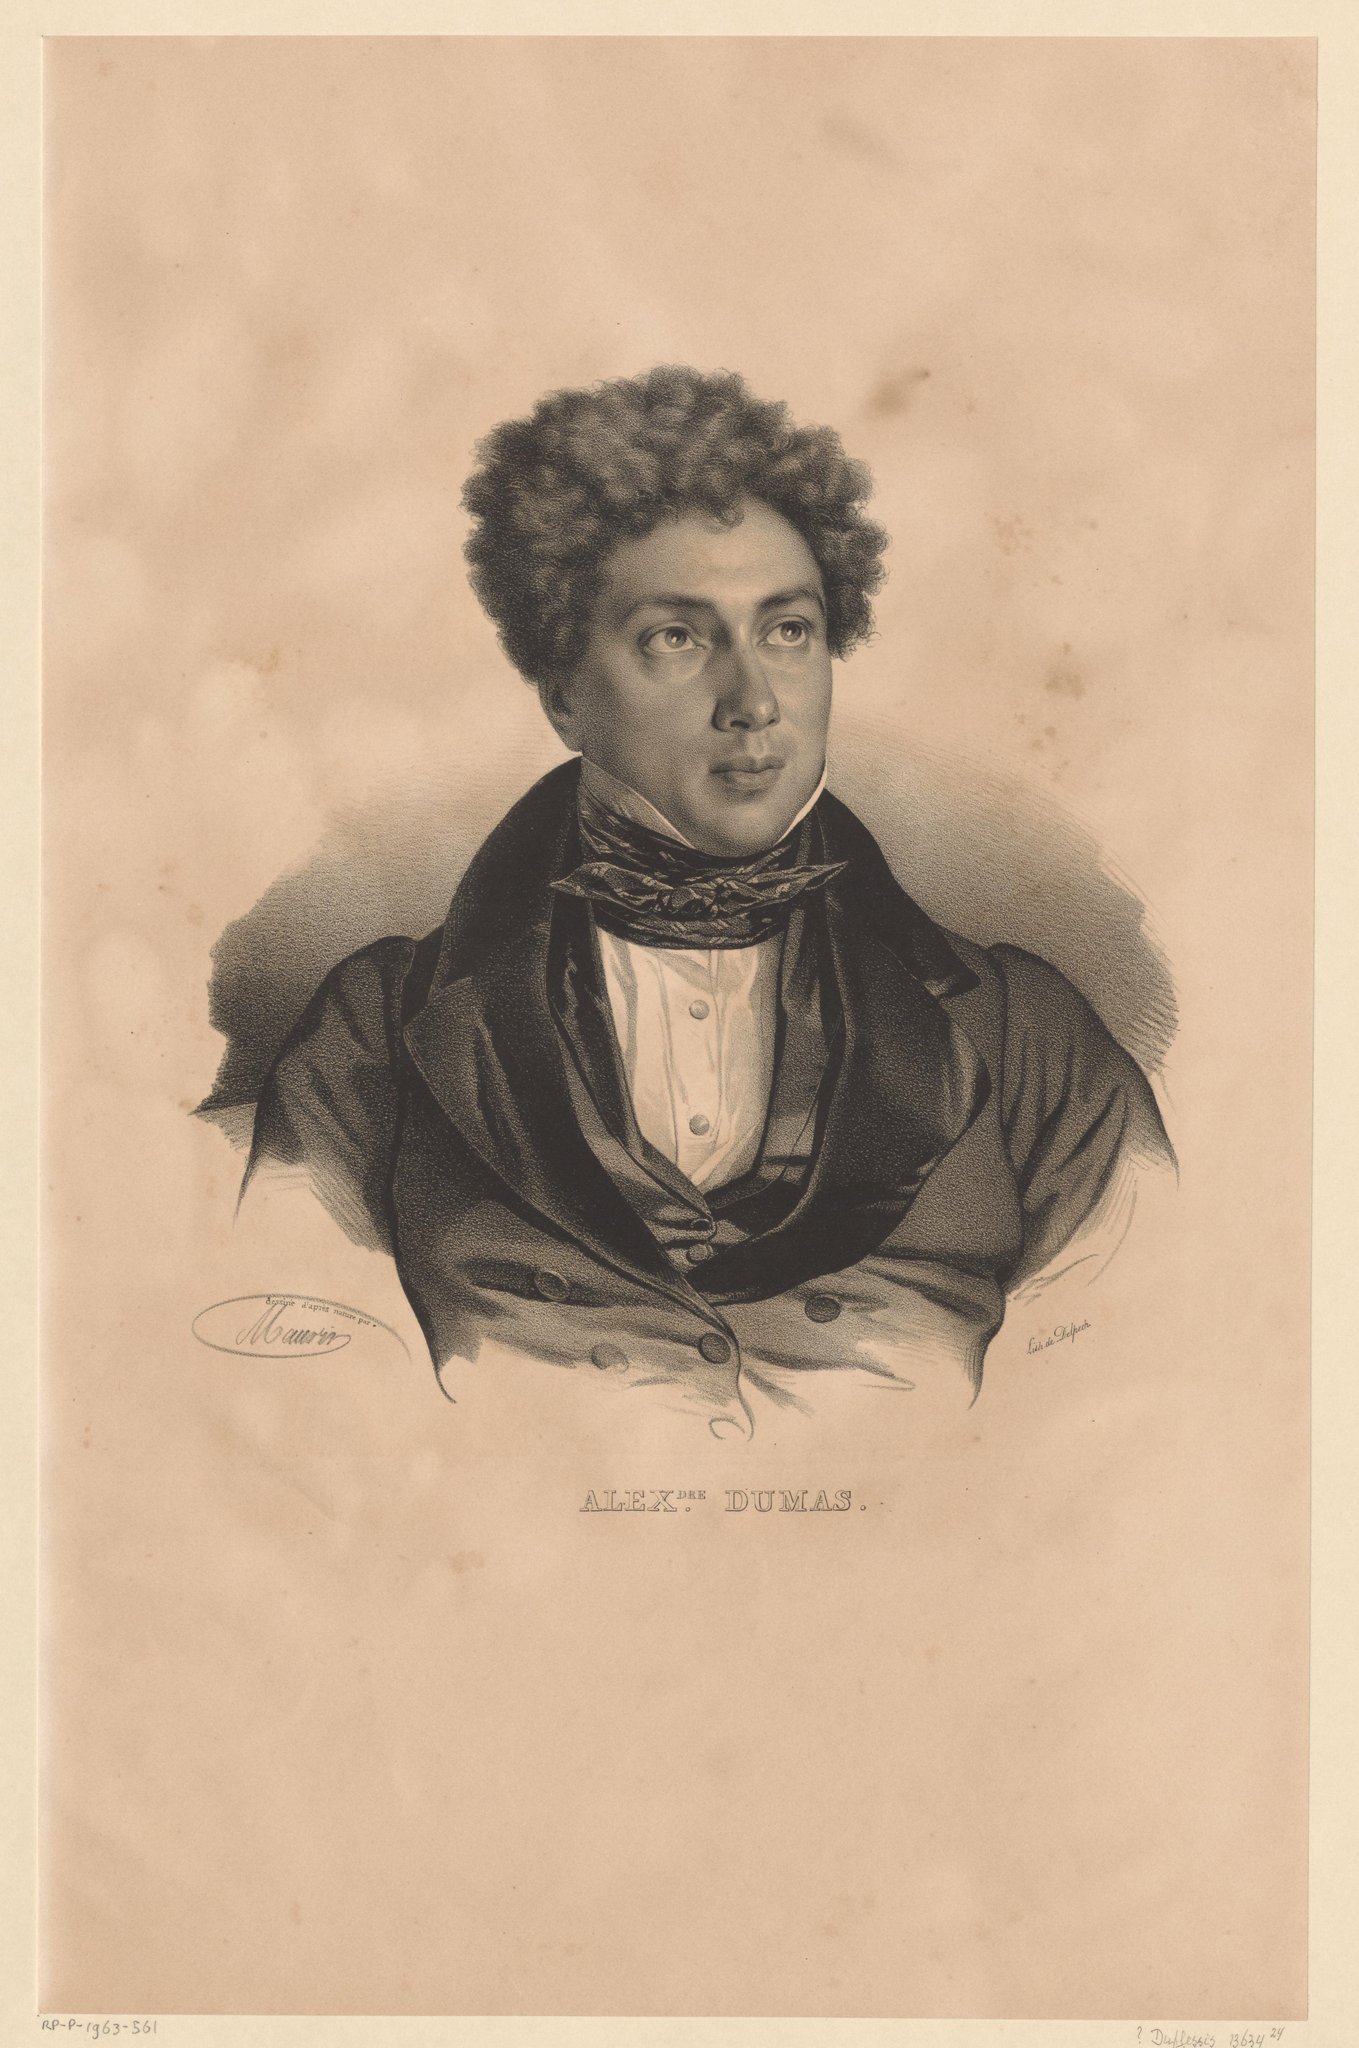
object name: print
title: Portret van Alexandre Dumas père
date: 1826-1842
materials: paper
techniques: lithograph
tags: historical persons, portrait of a writer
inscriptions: collector's mark: Lugt 2228